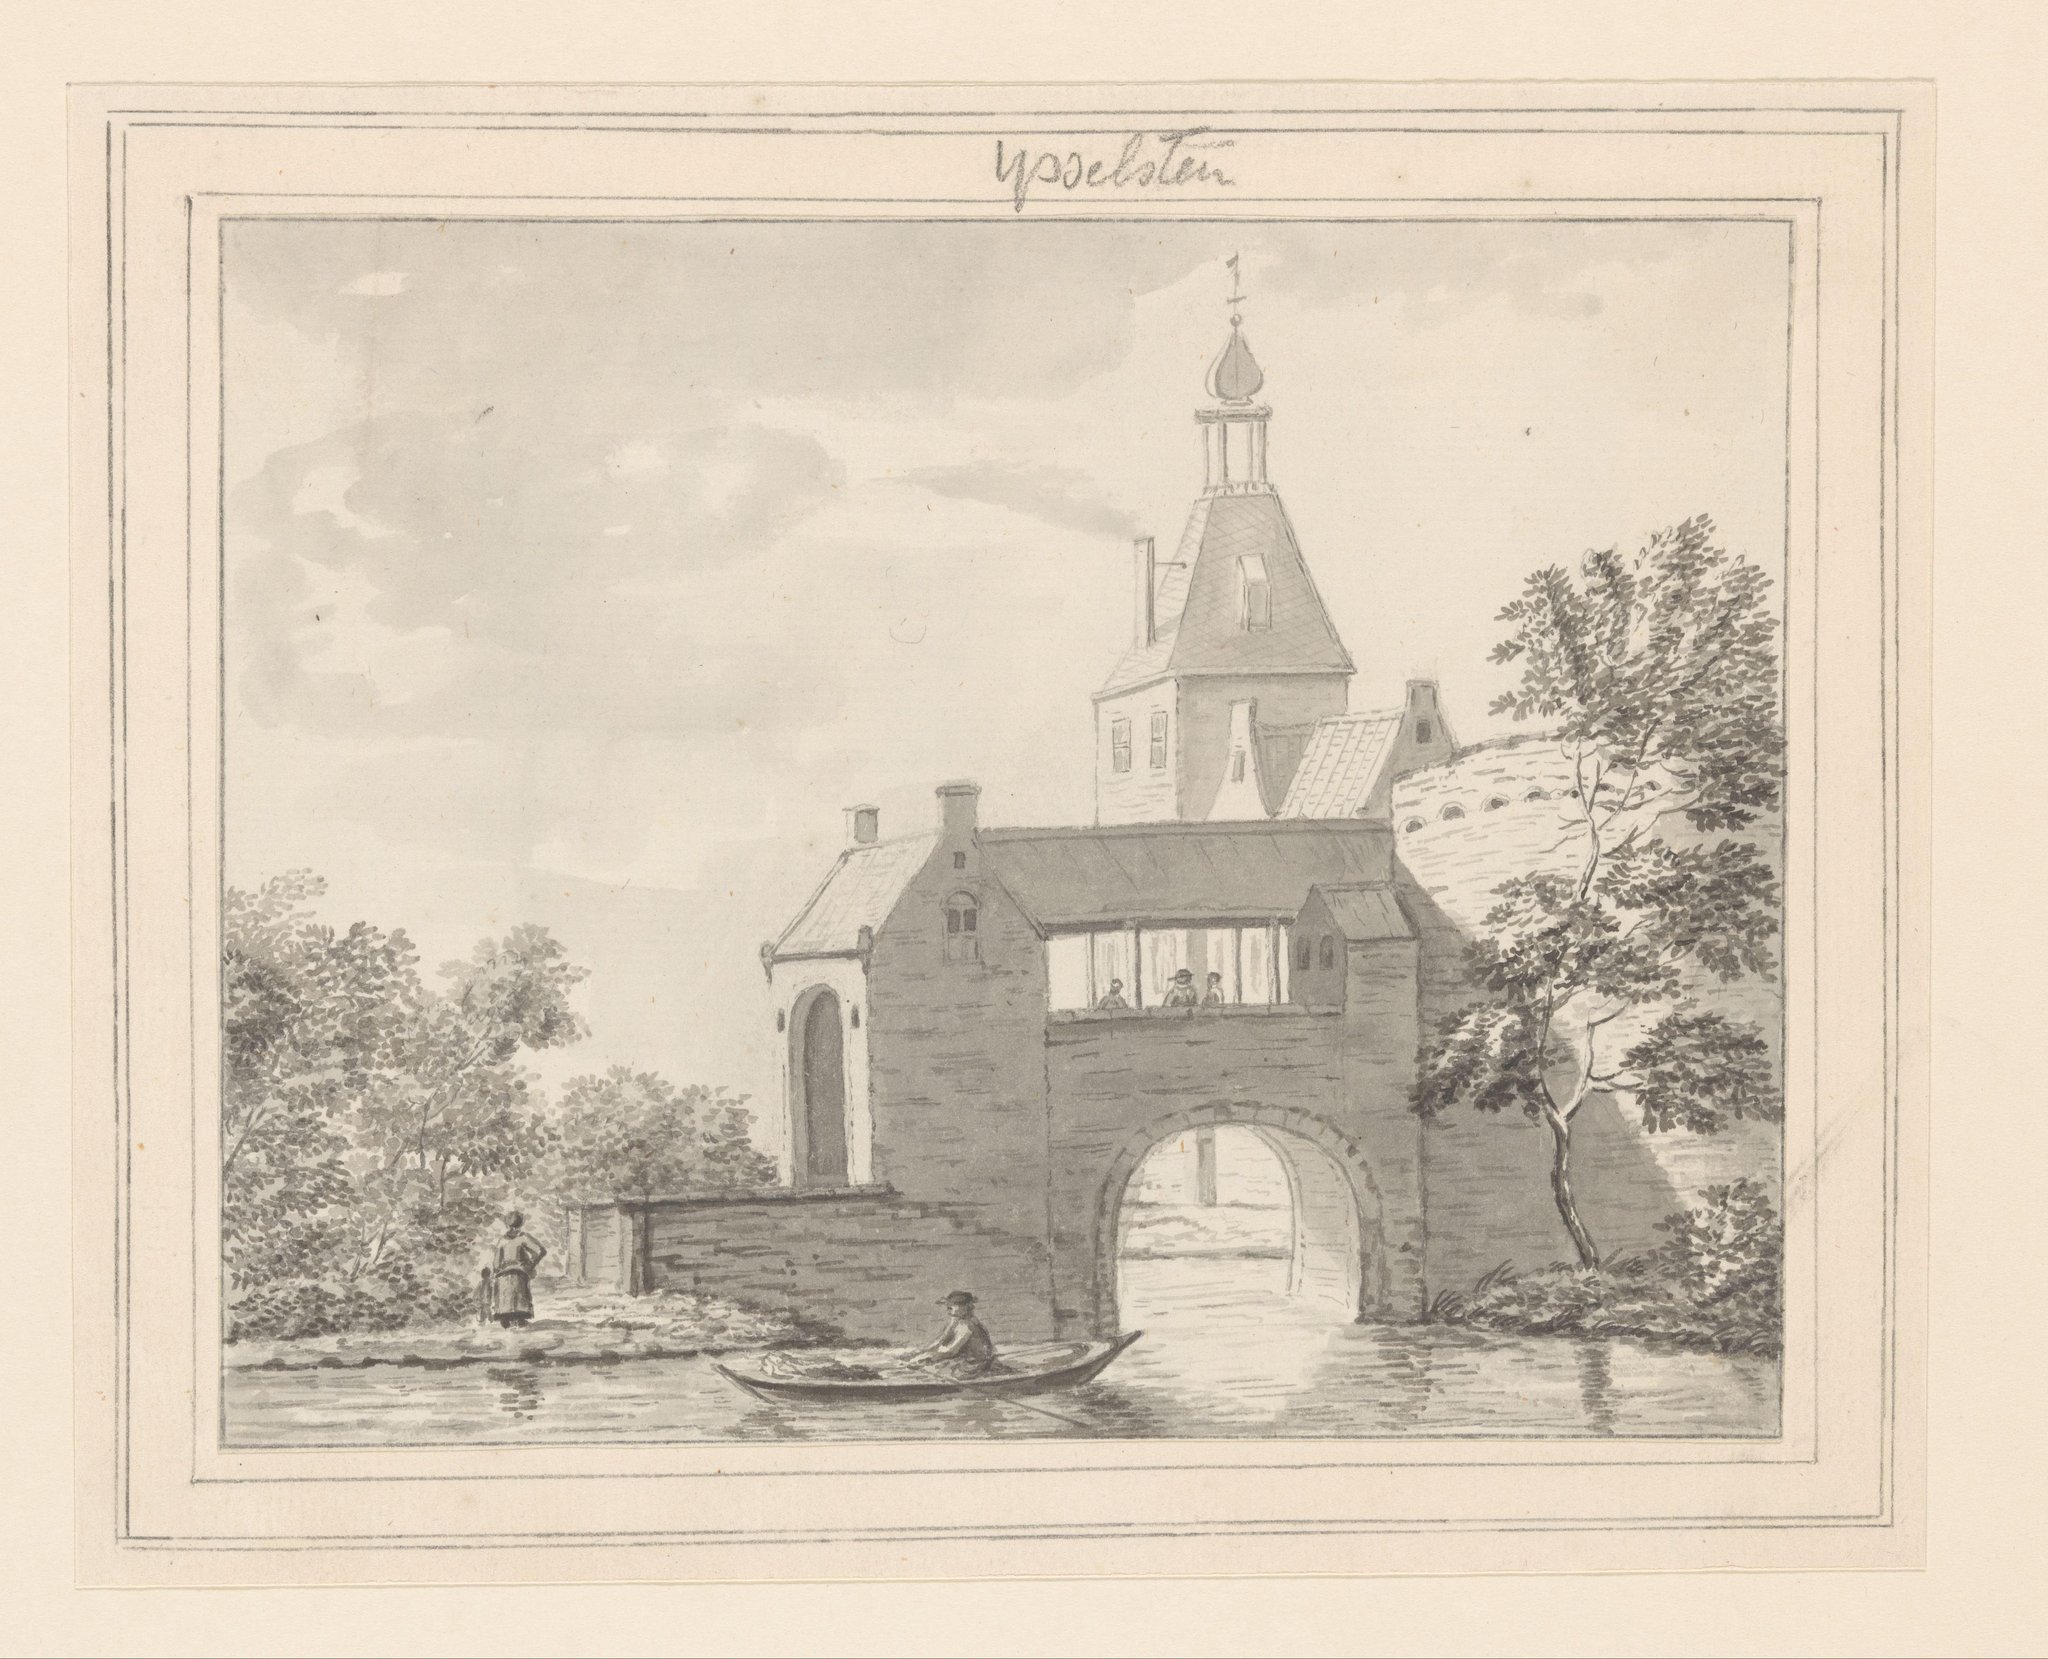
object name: drawing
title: Gezicht op de overdekte sluis bij de IJsselpoort in IJsselstein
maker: Anonymous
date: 1700-1799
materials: ink, paper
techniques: brush, drawing, pen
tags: sluice, weir, city-gate